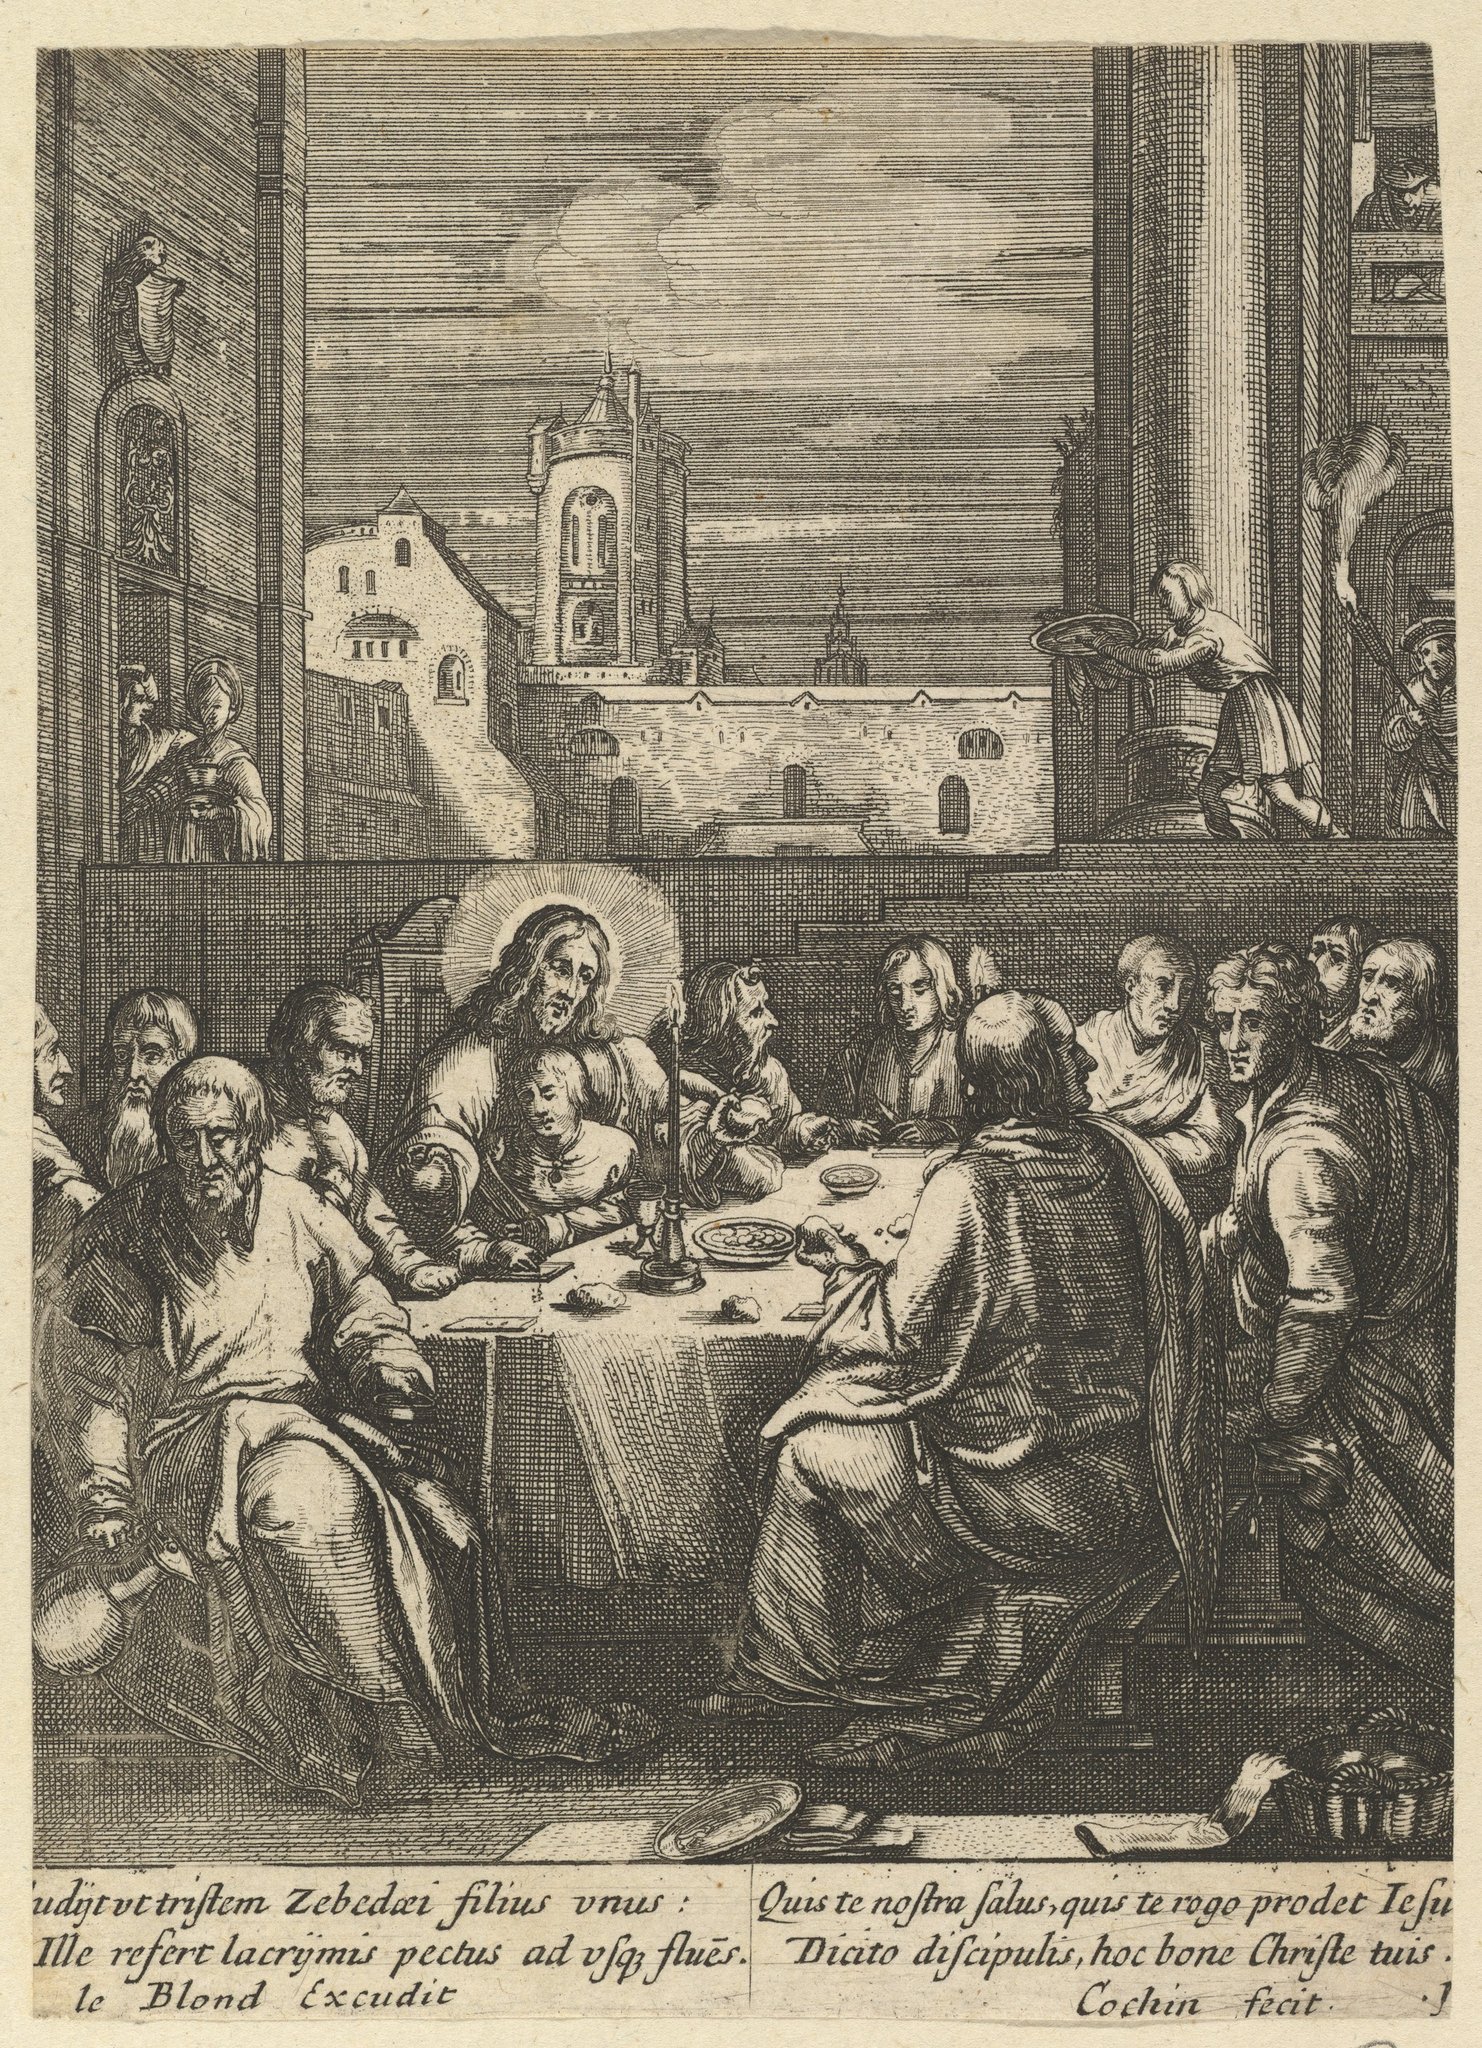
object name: print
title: The Last Supper, from "The Passion of Christ"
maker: nicolas cochin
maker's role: artist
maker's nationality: french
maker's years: 1610-1686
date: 1634-1666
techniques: etching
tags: men,women,christ,last supper